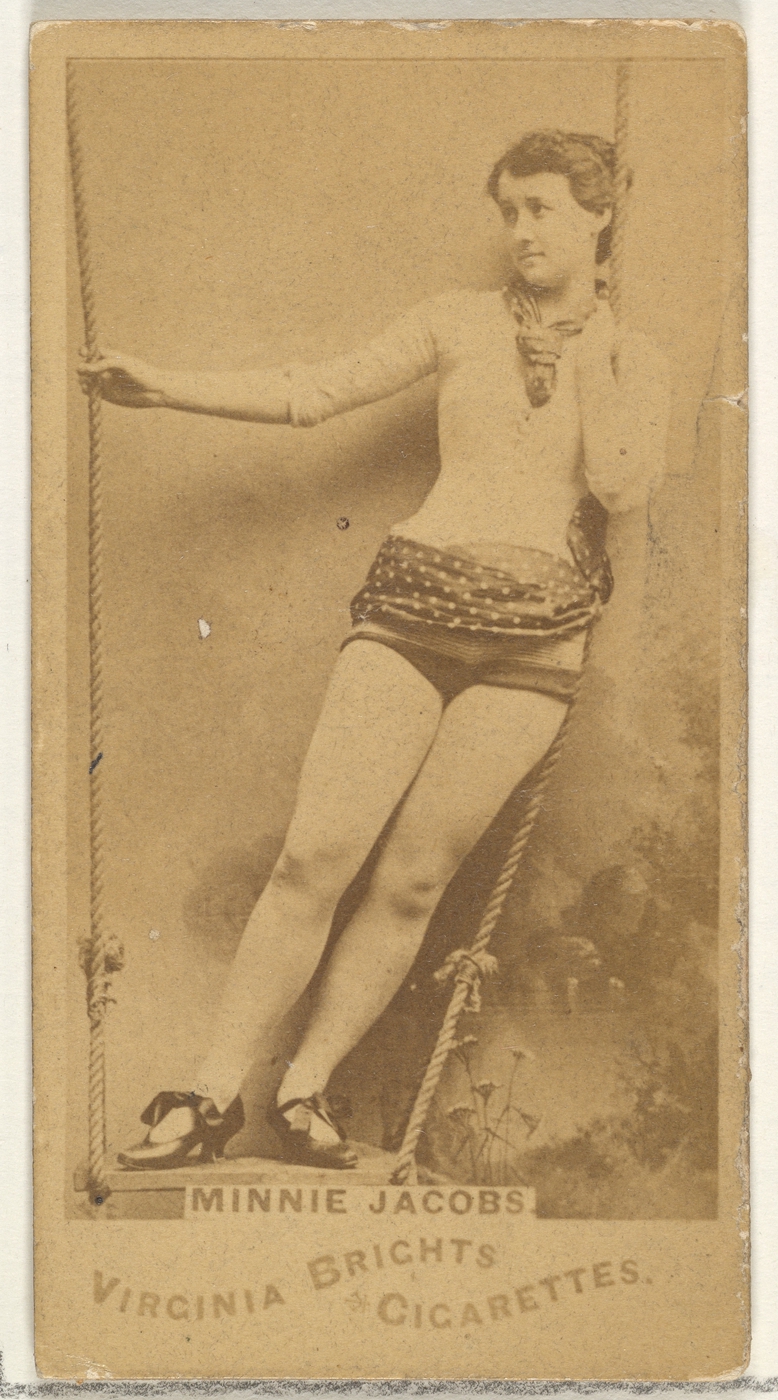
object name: photograph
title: Minnie Jacobs, from the Actors and Actresses series (N45, Type 1) for Virginia Brights Cigarettes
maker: allen & ginter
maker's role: publisher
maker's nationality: american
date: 1888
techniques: albumen silver print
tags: portraits,women,actresses